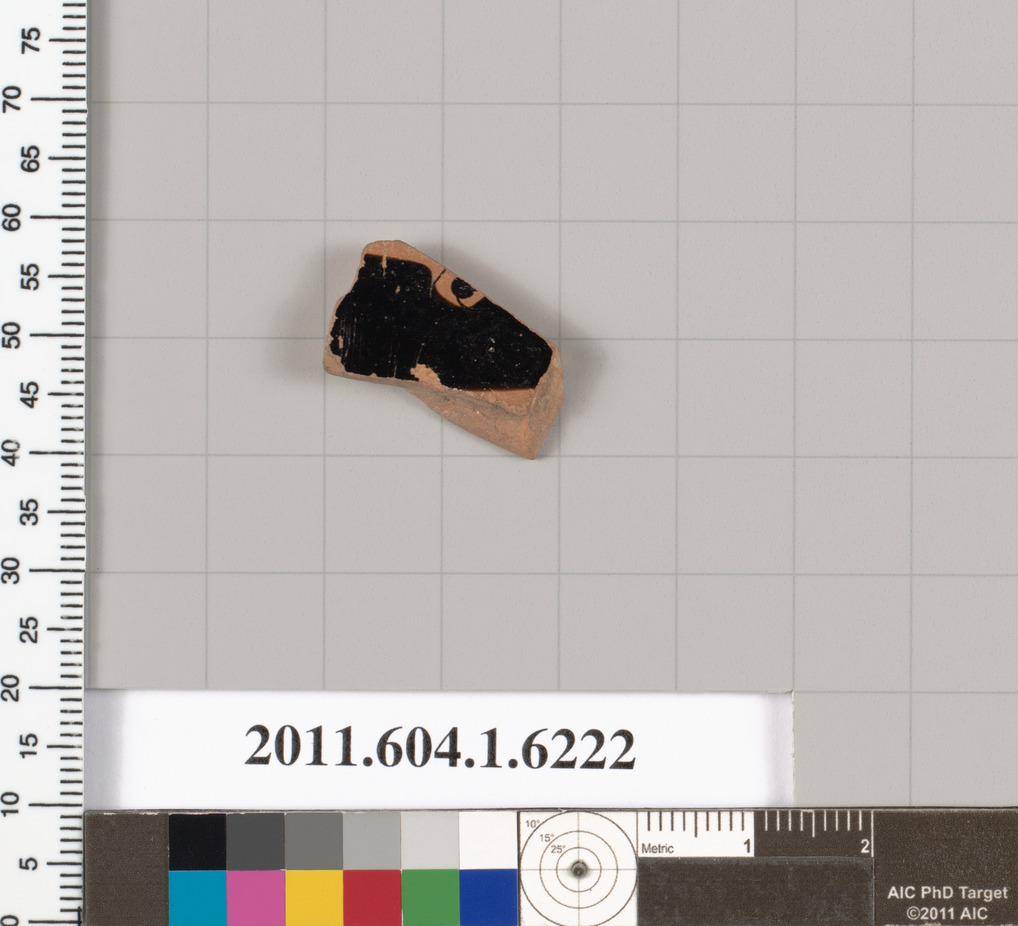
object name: kylix fragment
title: Terracotta fragment of a kylix (drinking cup)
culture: greek, attic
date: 510-500 BCE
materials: terracotta